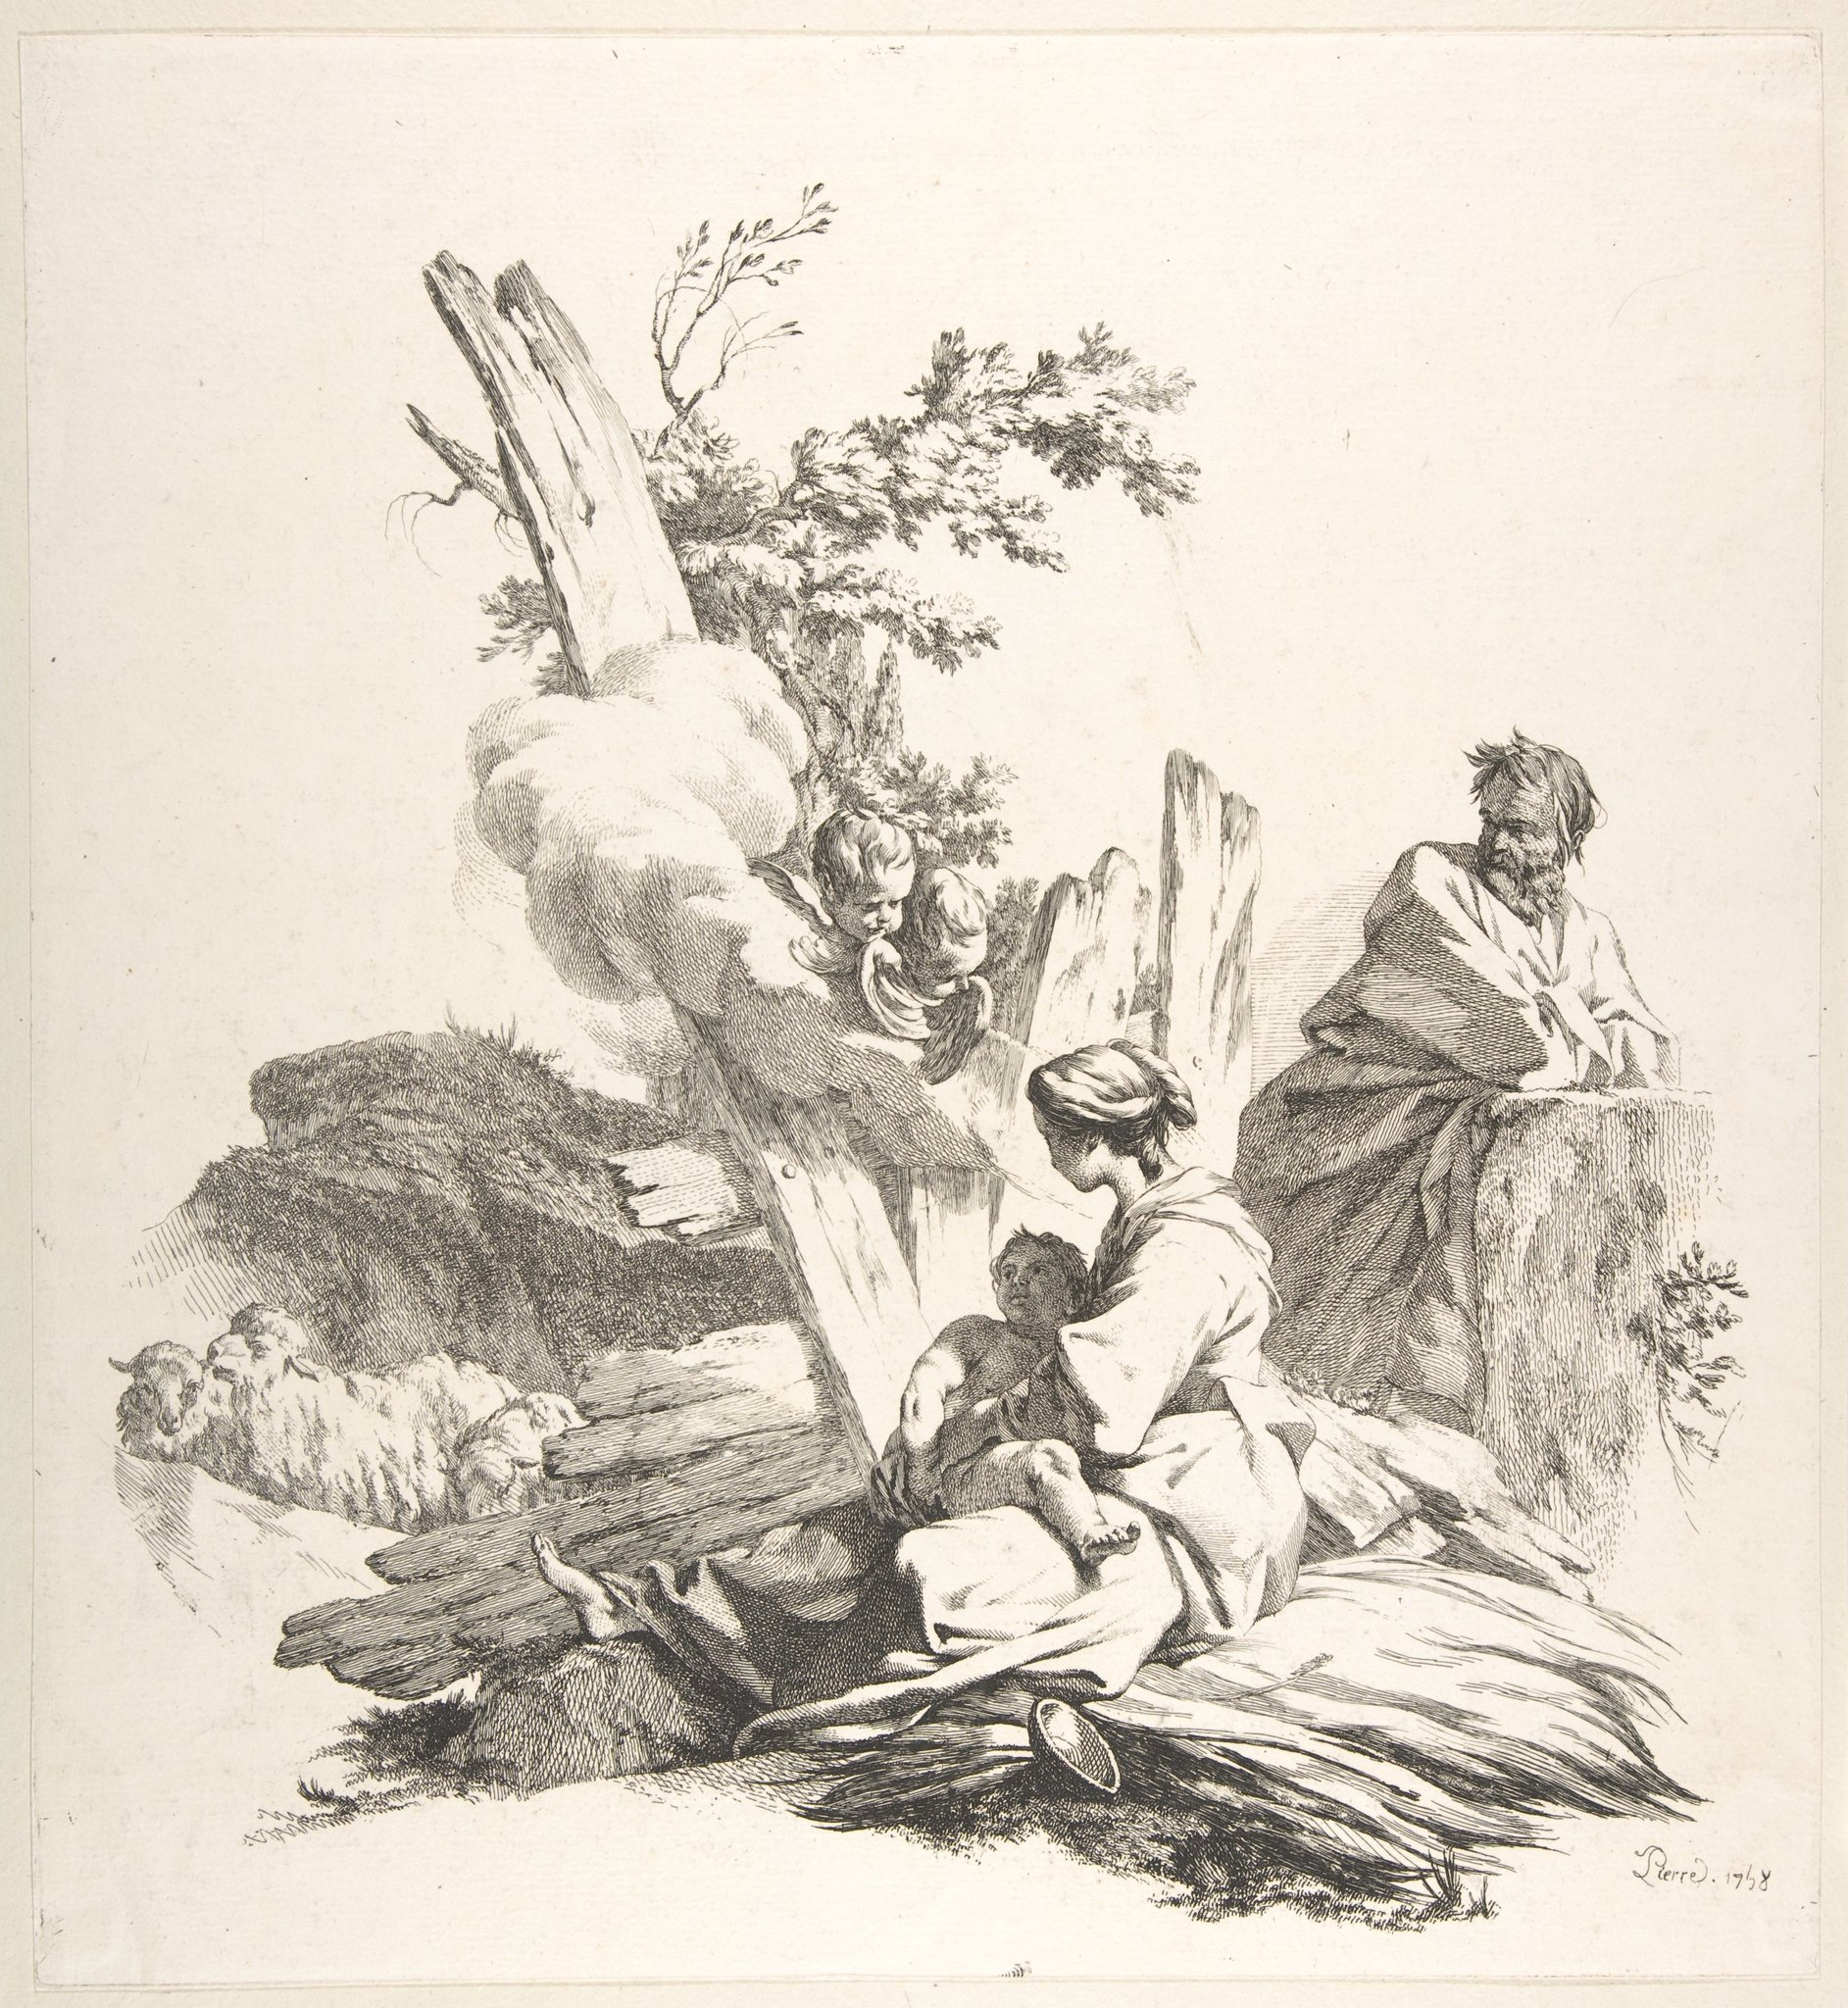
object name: print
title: The Flight Into Egypt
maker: jean-baptiste marie pierre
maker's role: artist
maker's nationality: french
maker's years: 1714-1789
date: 1758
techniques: etching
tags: men,angels,virgin mary,jesus,saints